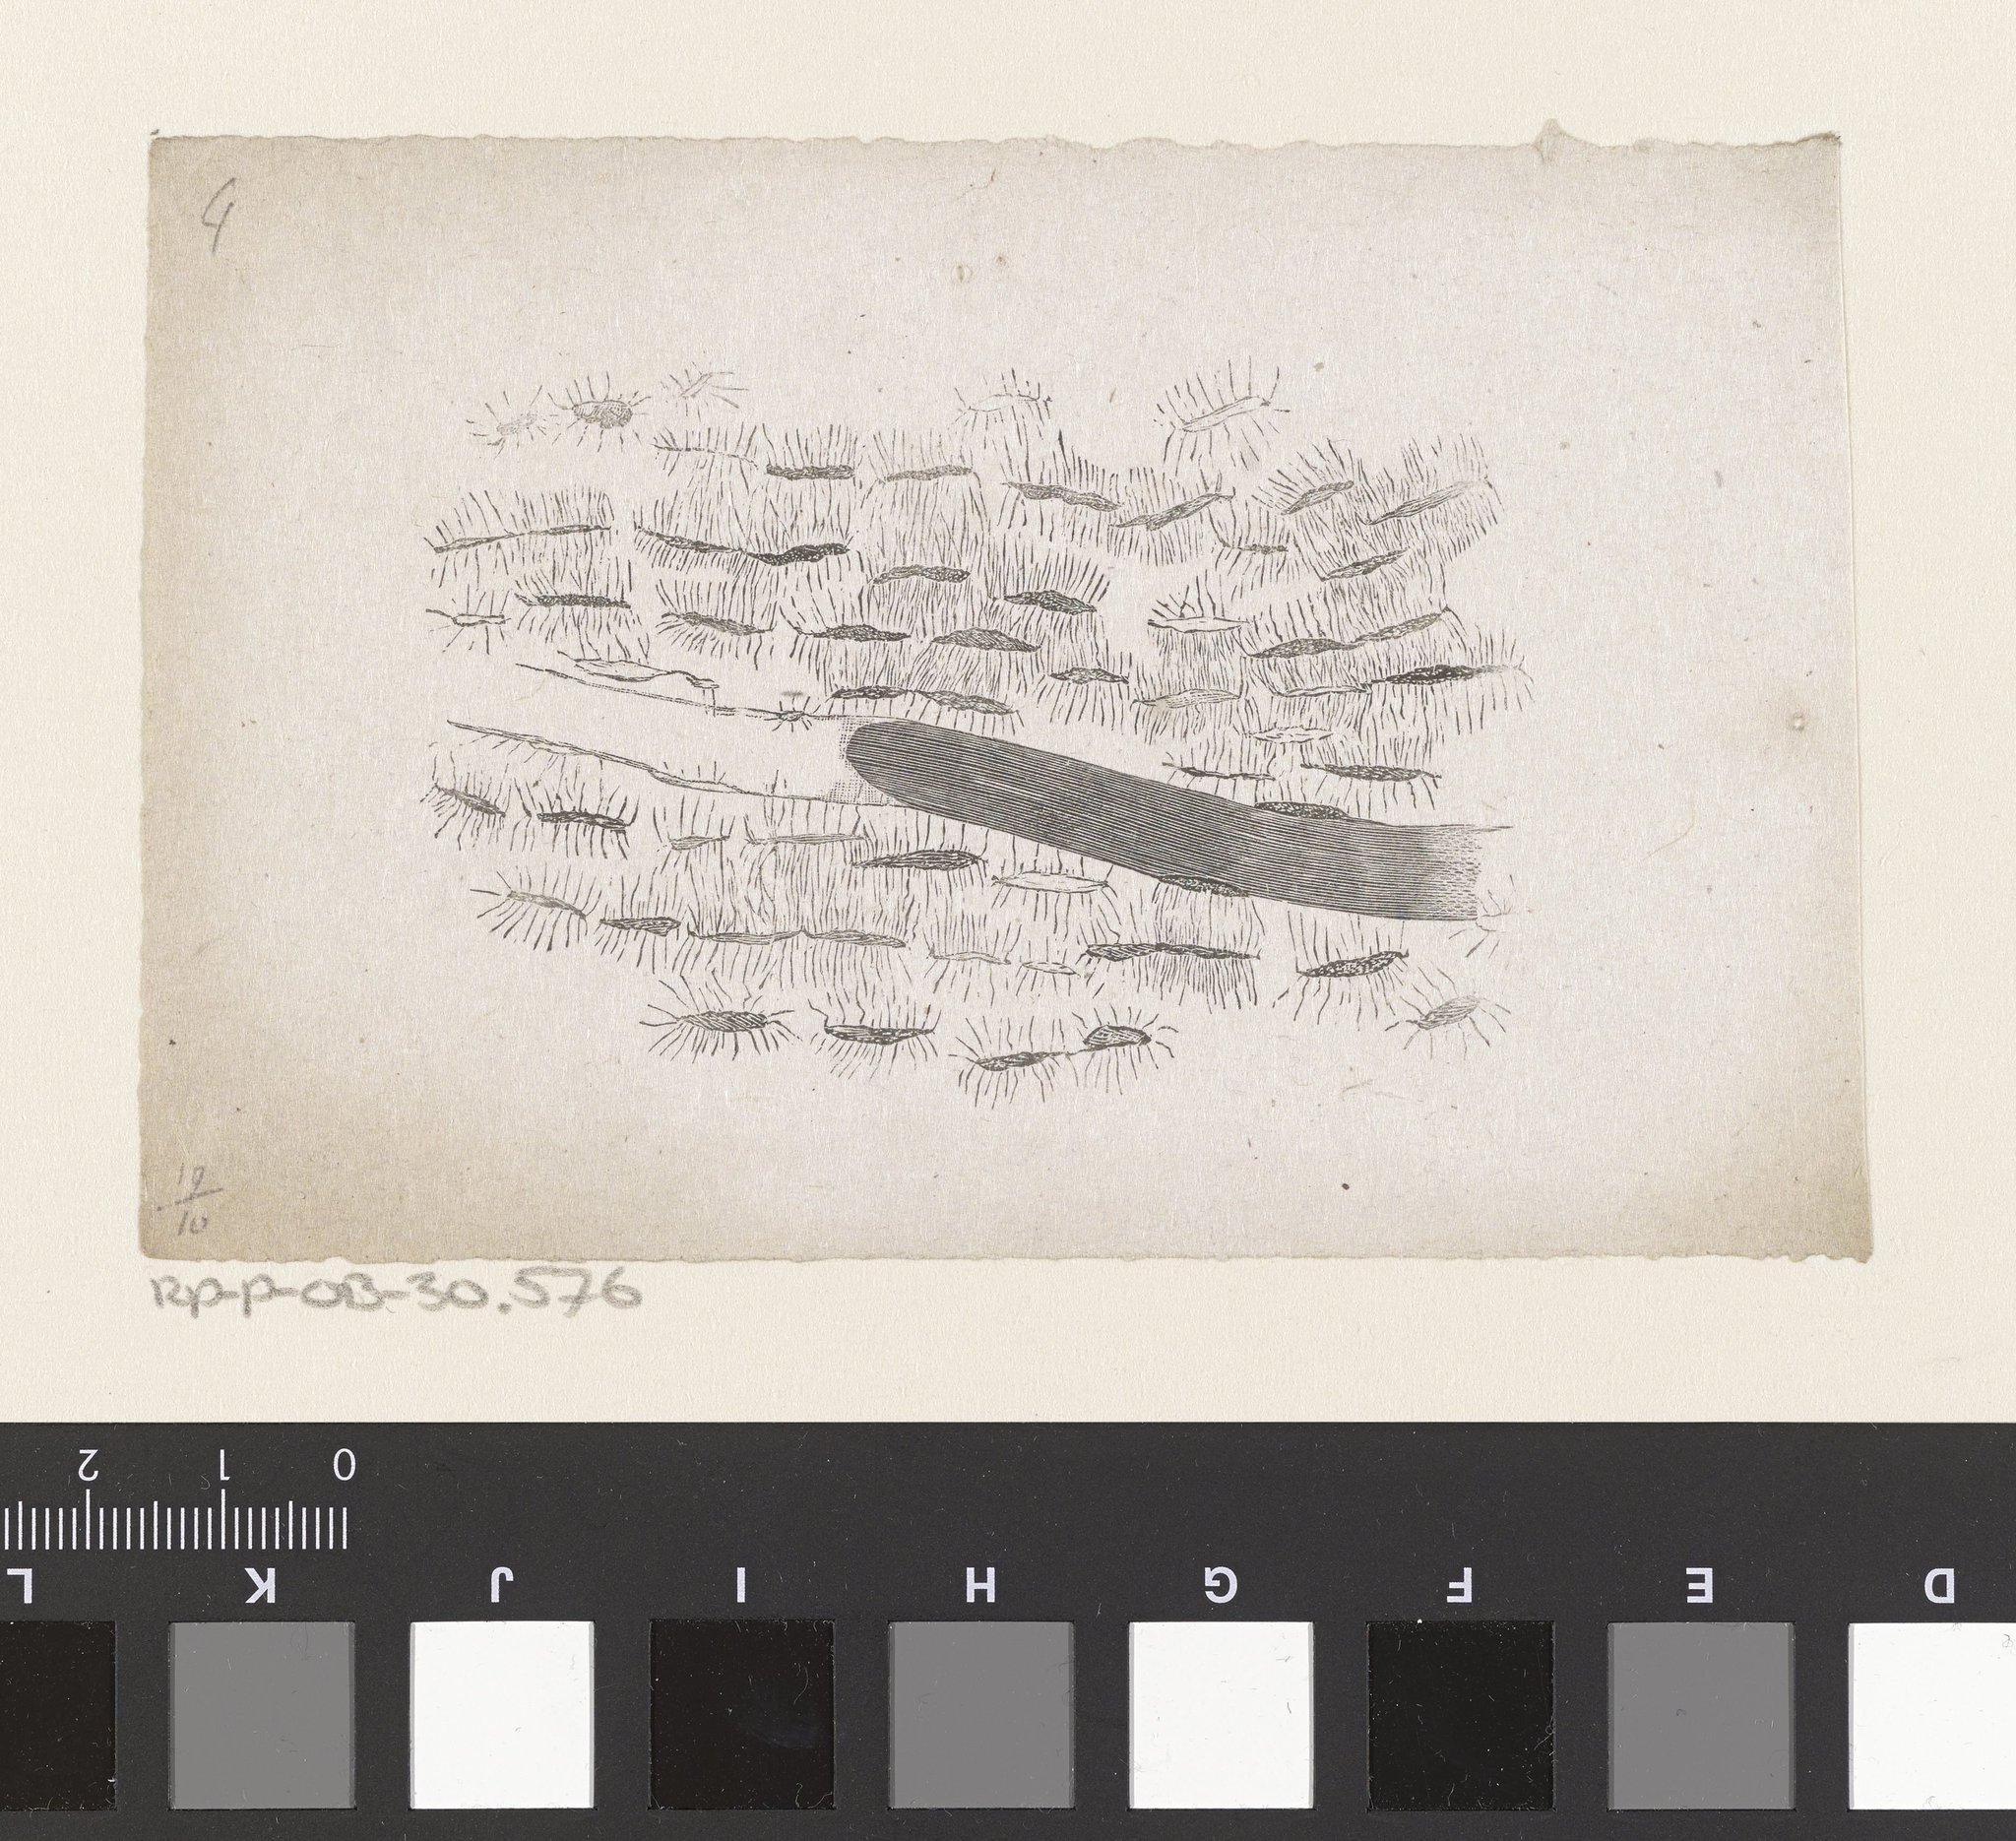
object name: print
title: Onderdeel van het menselijk lichaam met een afwijking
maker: isaac weissenbruch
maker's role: print maker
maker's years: 1826-1912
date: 1836-1912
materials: paper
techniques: engraving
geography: netherlands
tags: anatomy (non-medical), diseases